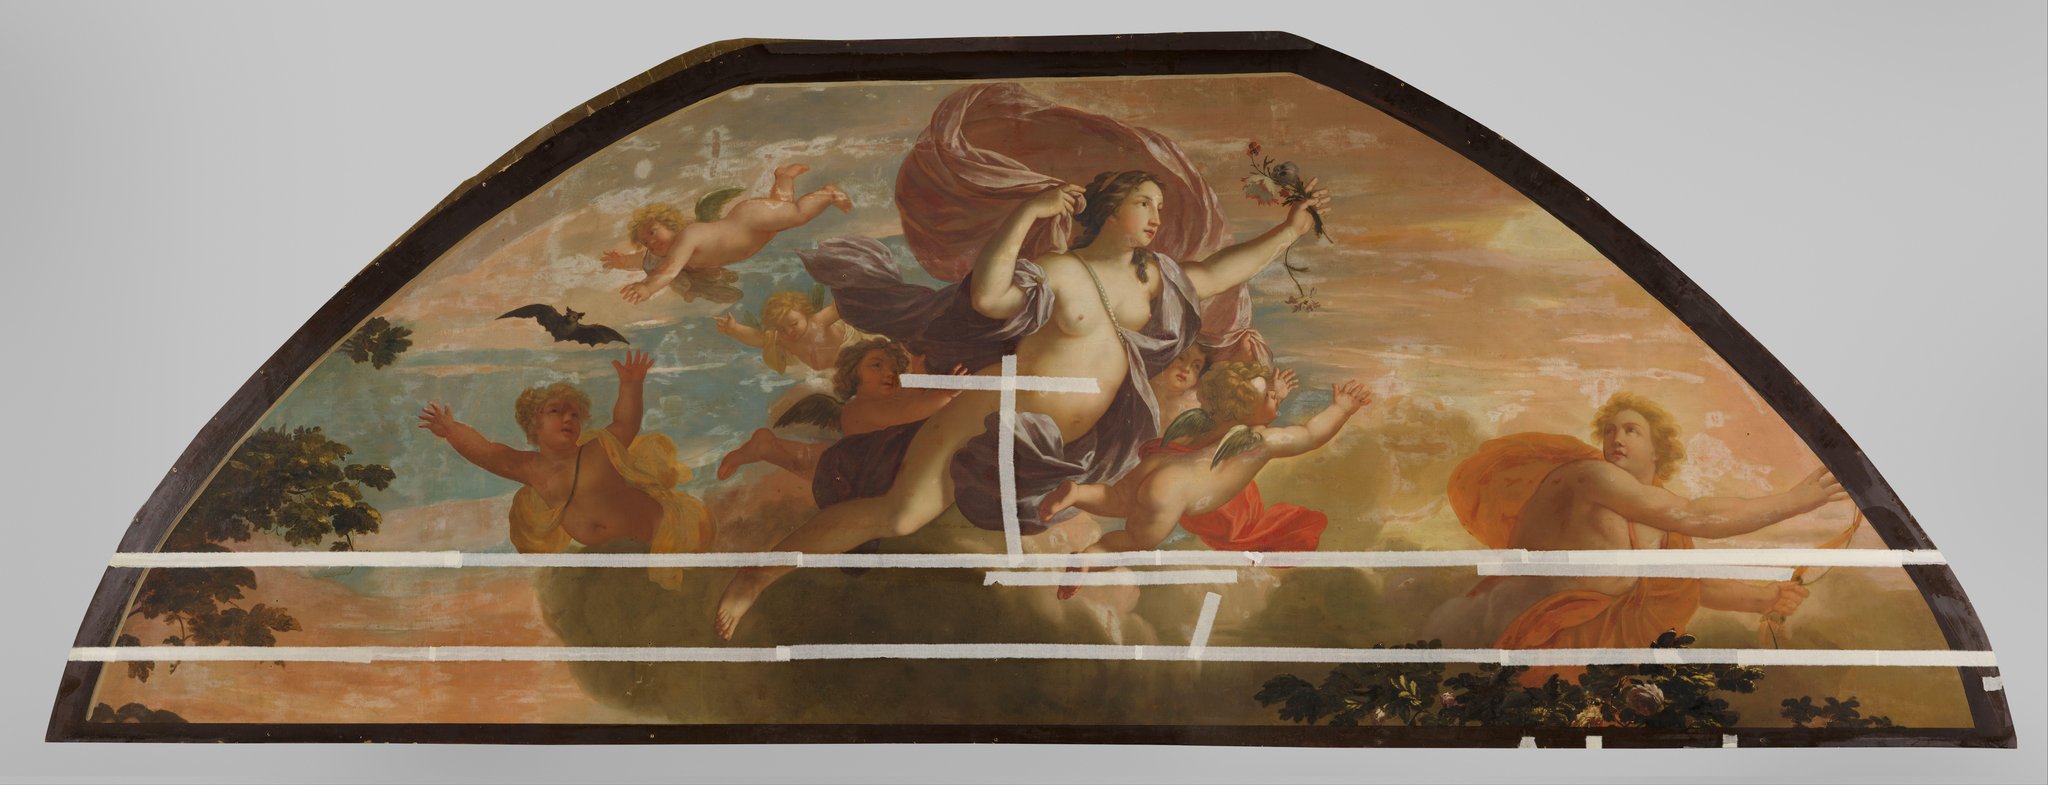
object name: painting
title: Plafondschildering met allegorische voorstelling van de Ochtend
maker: theodoor van der schuer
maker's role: draughtsman, painter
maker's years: 1634-1707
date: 1666-1695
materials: oil, panel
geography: netherlands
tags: maria ii stuart (koningin van engeland, schotland en ierland)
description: Afkomstig uit de slaapkamer van Mary Stuart, de vrouw van prins Willem III. De kamer bevond zich in de stadhouderlijke verblijven aan het Binnenhof in Den Haag.